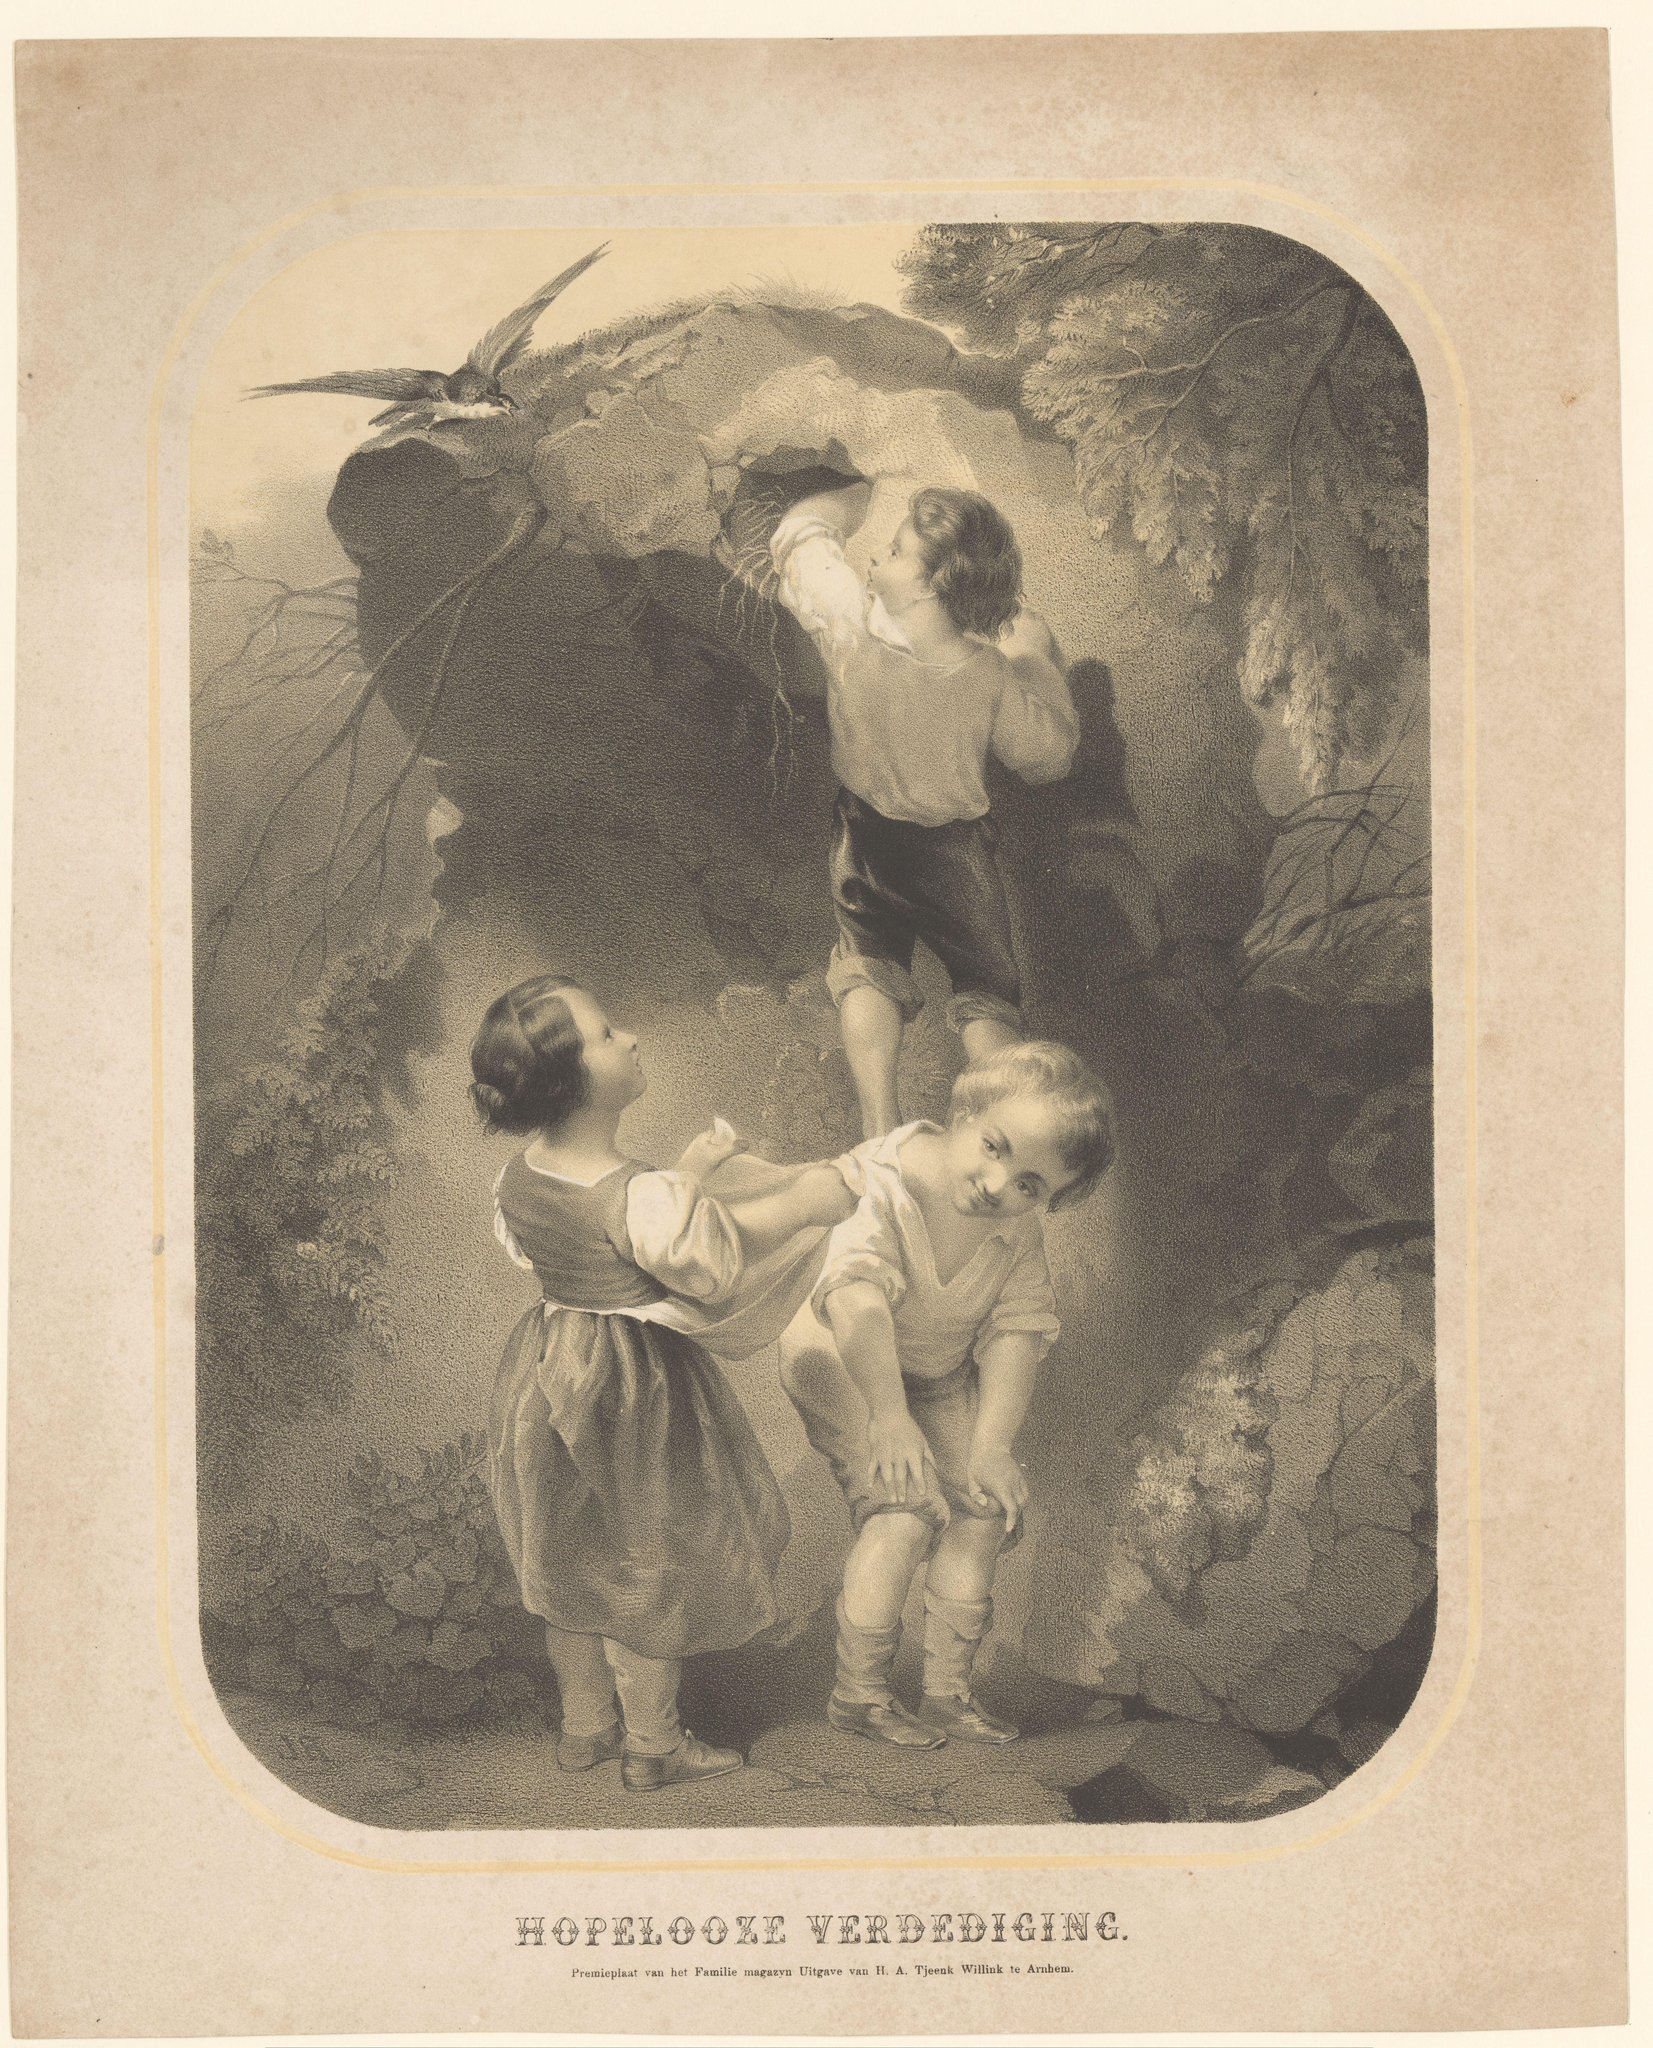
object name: print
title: Hopelooze verdediging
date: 1854-1886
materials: paper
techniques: tone lithography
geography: arnhem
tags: child robbing bird's nests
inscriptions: collector's mark: Lugt 2228, monogram: ‘BL’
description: Verschenen als premieplaat bij het Familie Magazyn.